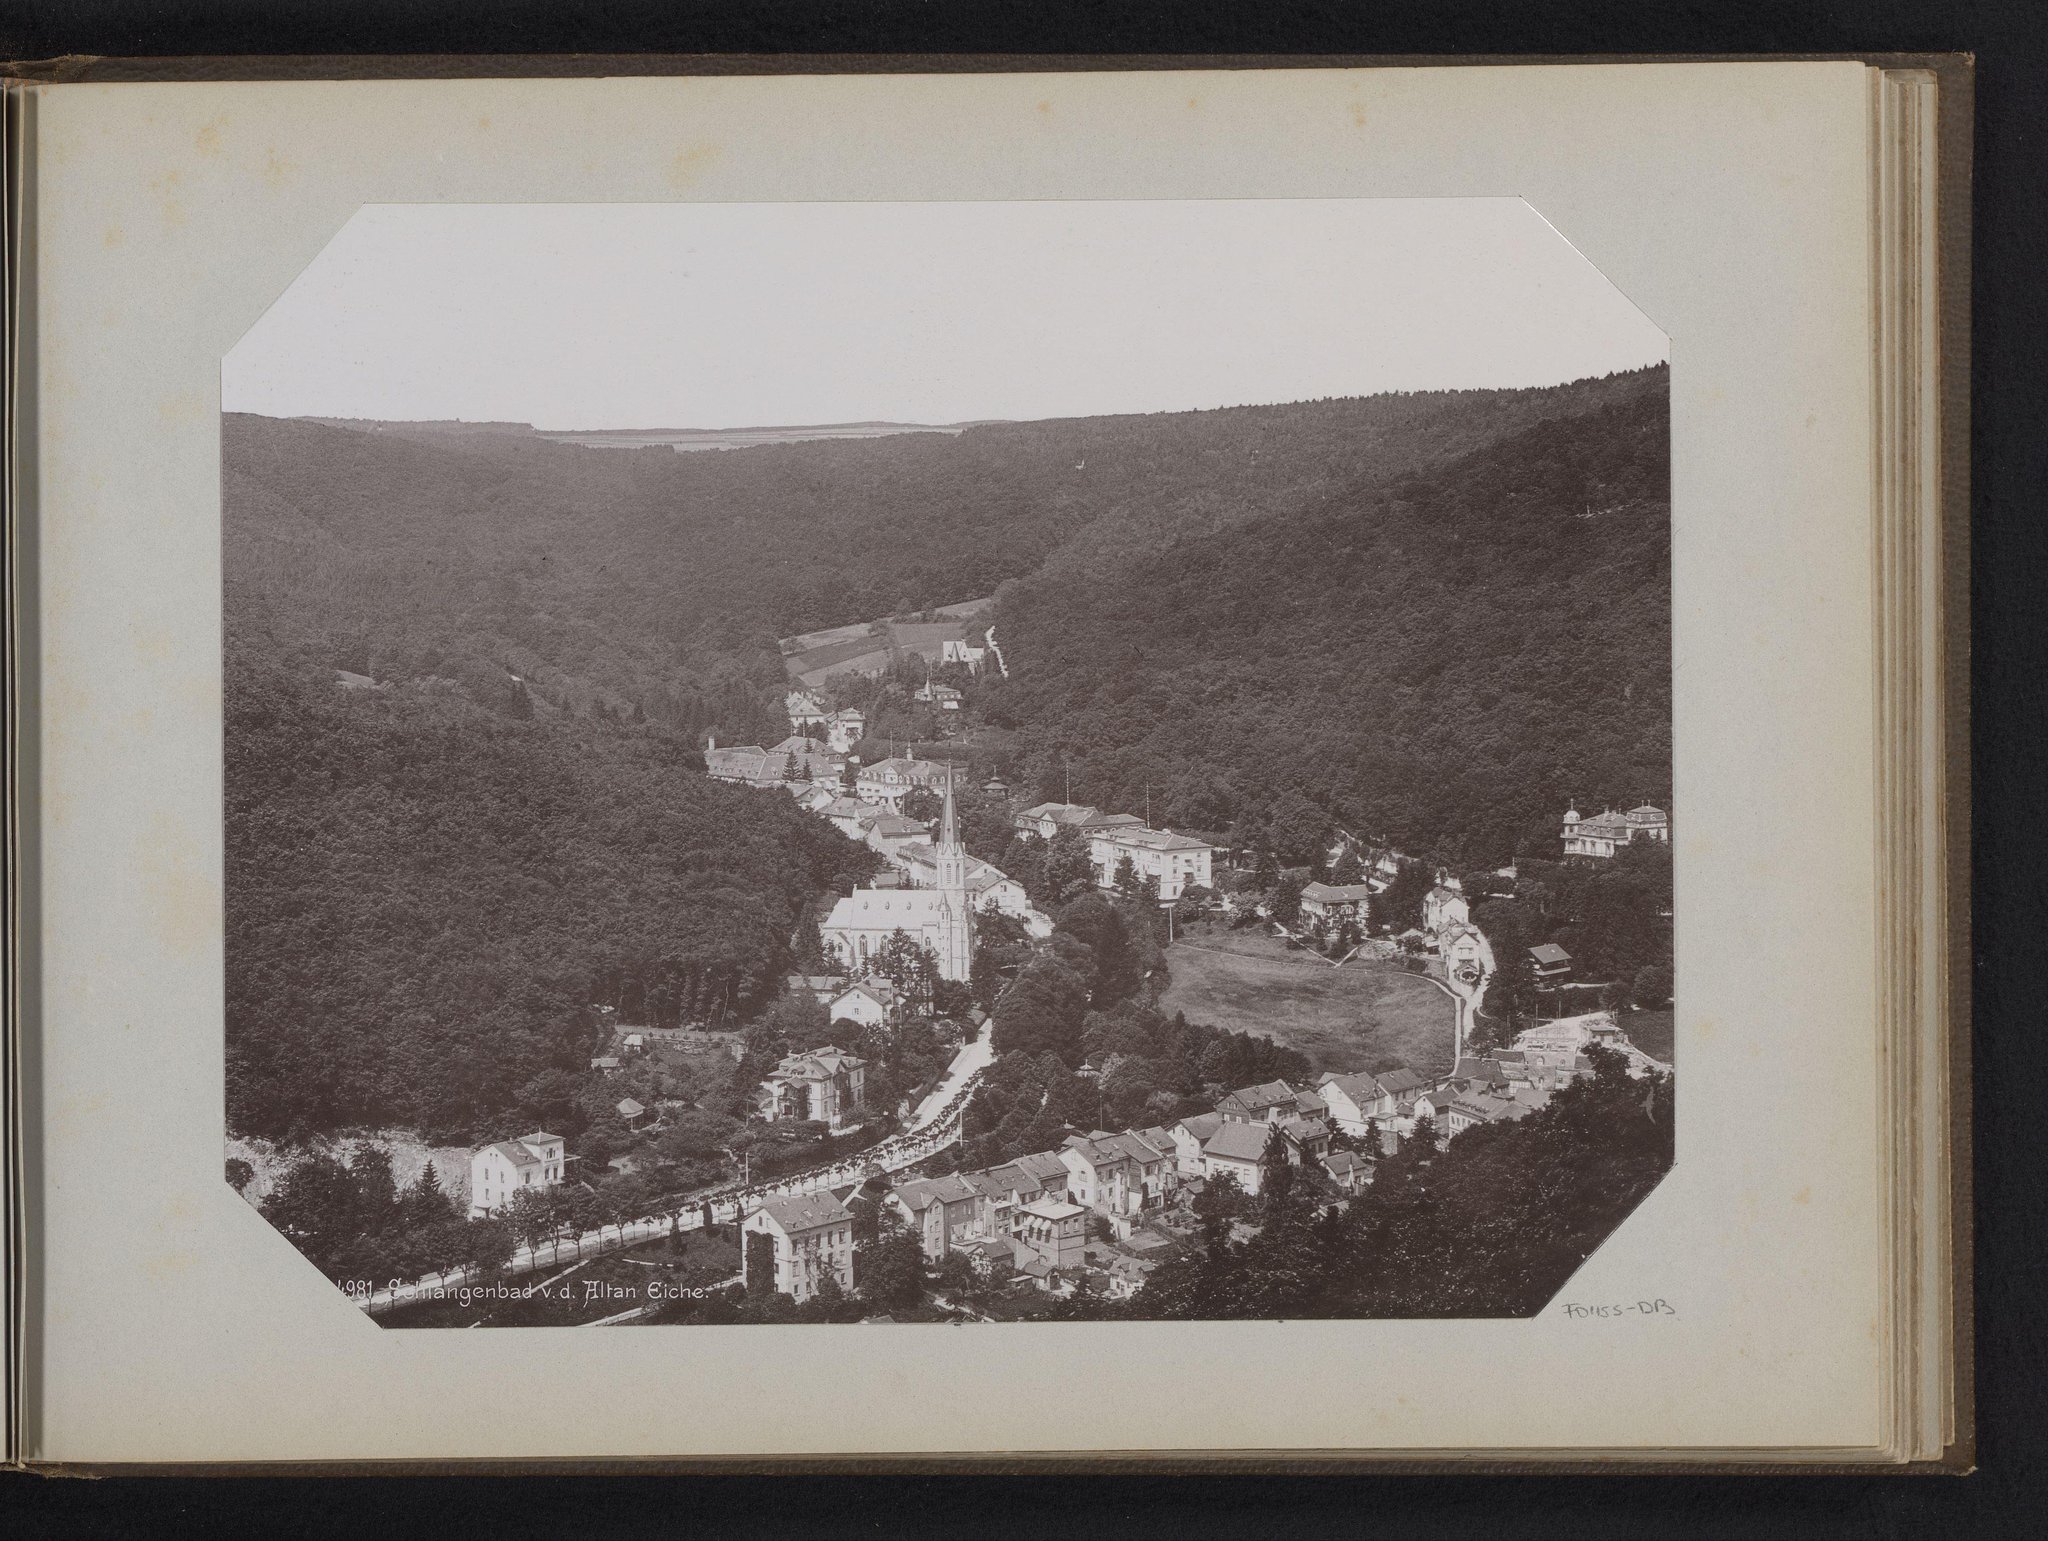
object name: photomechanical print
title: Gezicht op Schlangenbad v.d. Altan Eiche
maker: Anonymous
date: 1890-1899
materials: paper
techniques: photograph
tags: city-view in general; 'veduta', church (exterior)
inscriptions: inscription: ‘4981. Schlangenbad v.d. Altan Eiche.’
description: Deze prent maakt deel uit van een album.